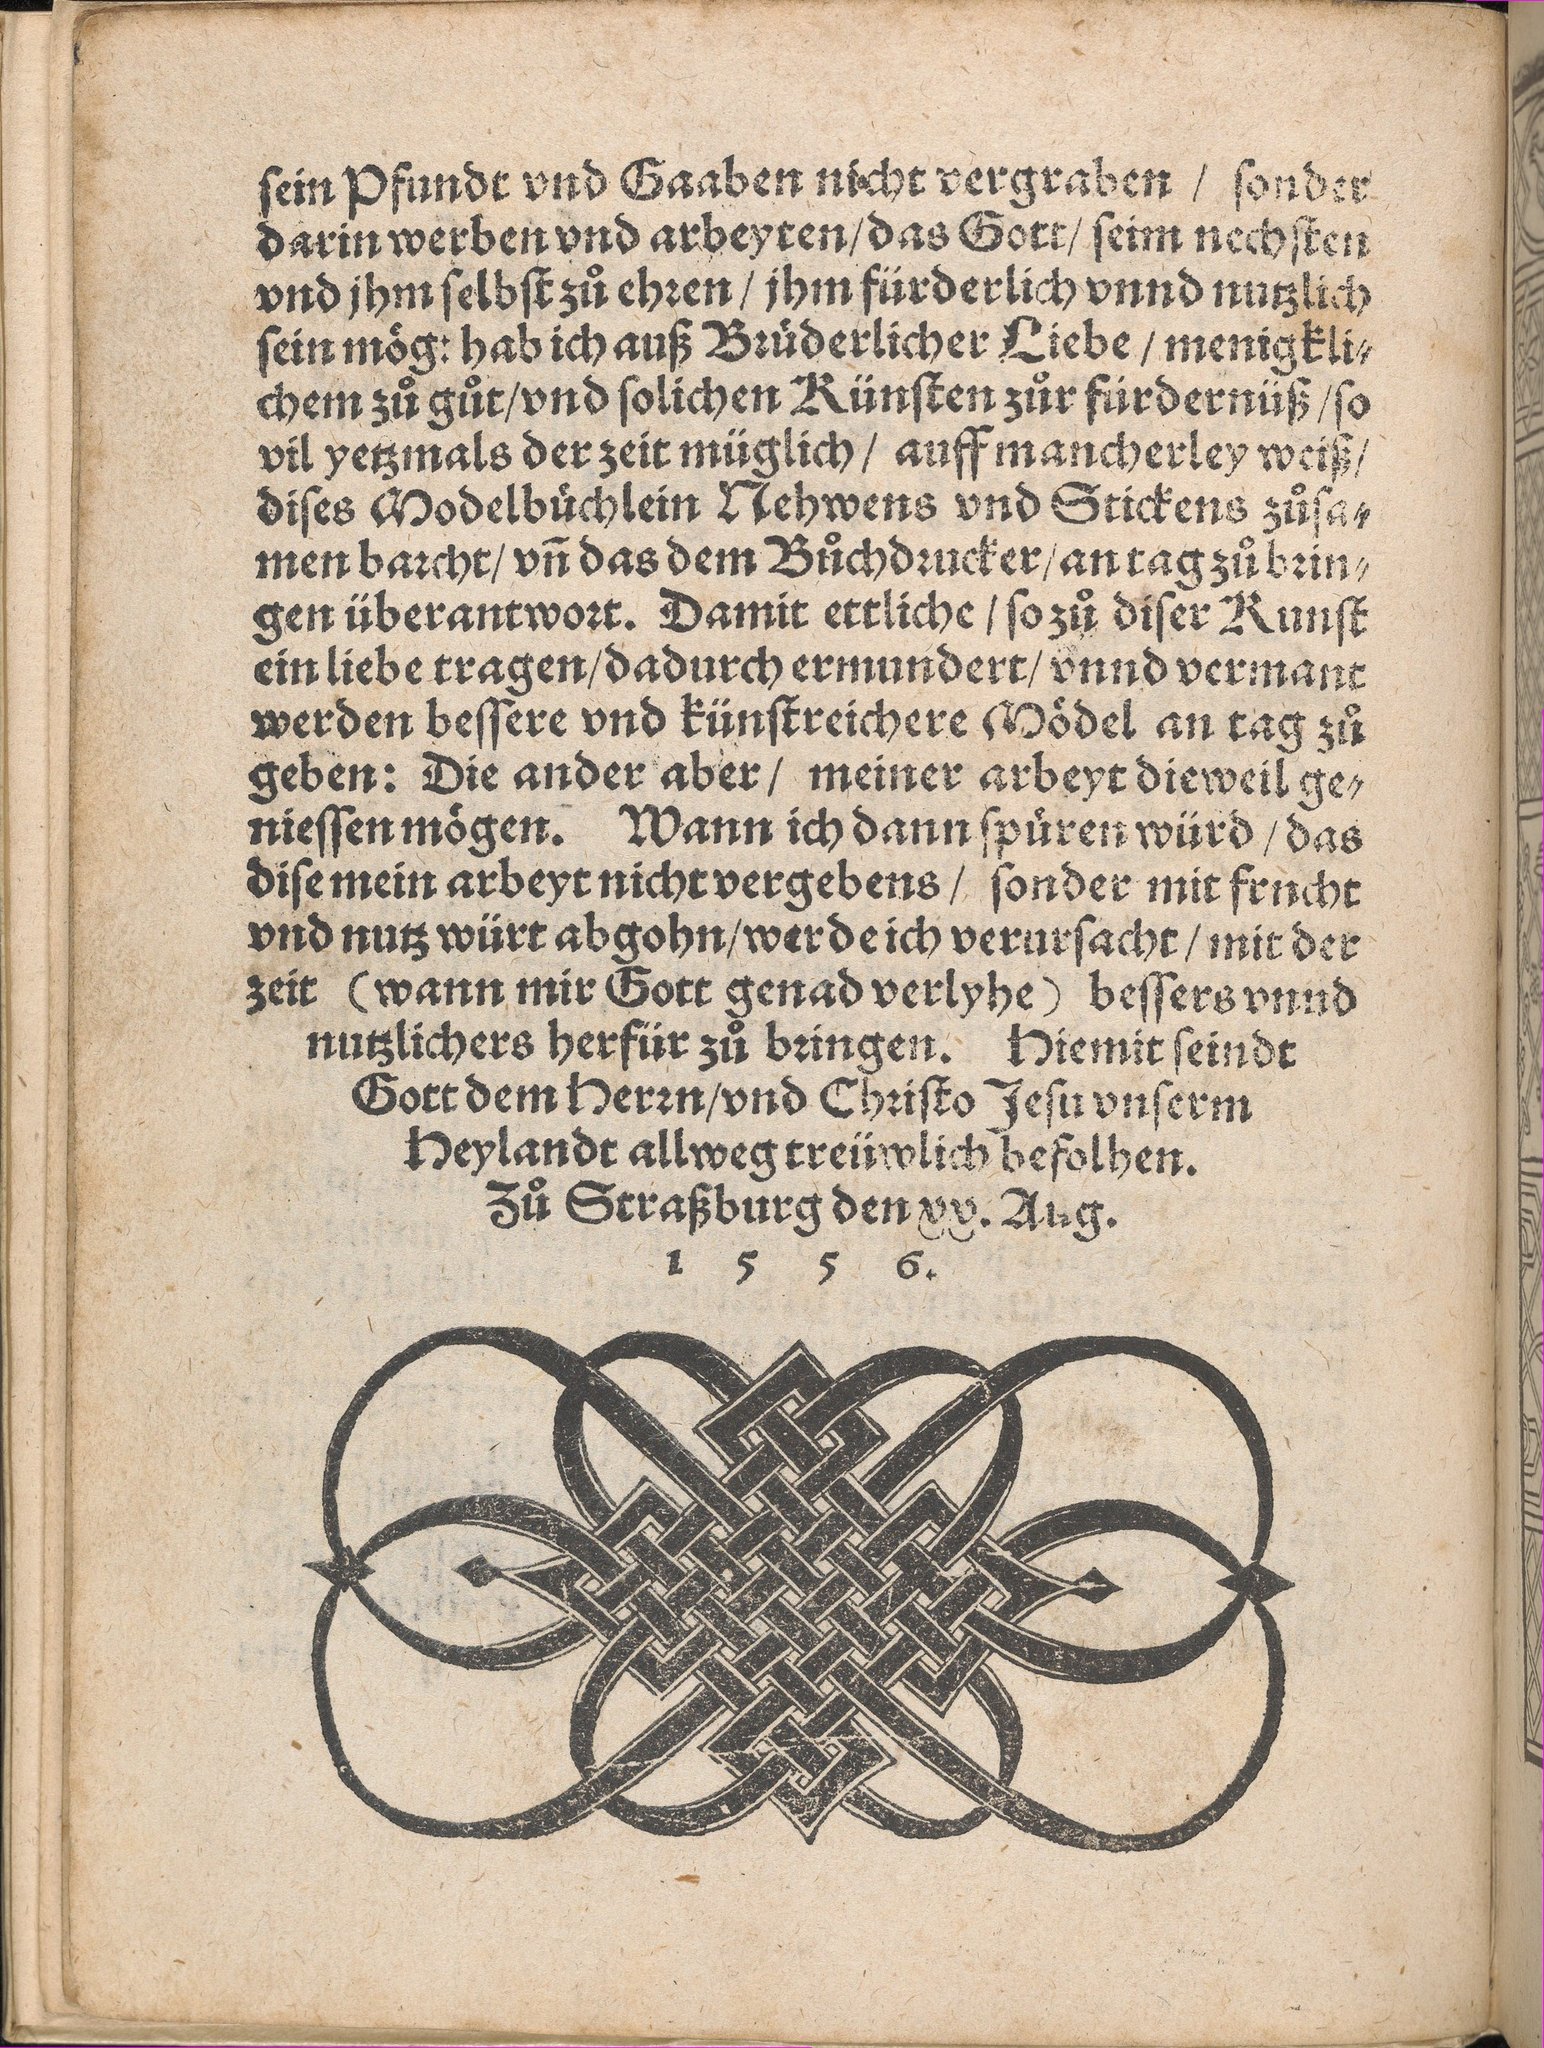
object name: book print ornament architecture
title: New Modelbüch allen Nägerin u. Sydenstickern (dedicatory page, 2v)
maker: hans hoffman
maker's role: designer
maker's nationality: german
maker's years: 1556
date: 1556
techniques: woodcut